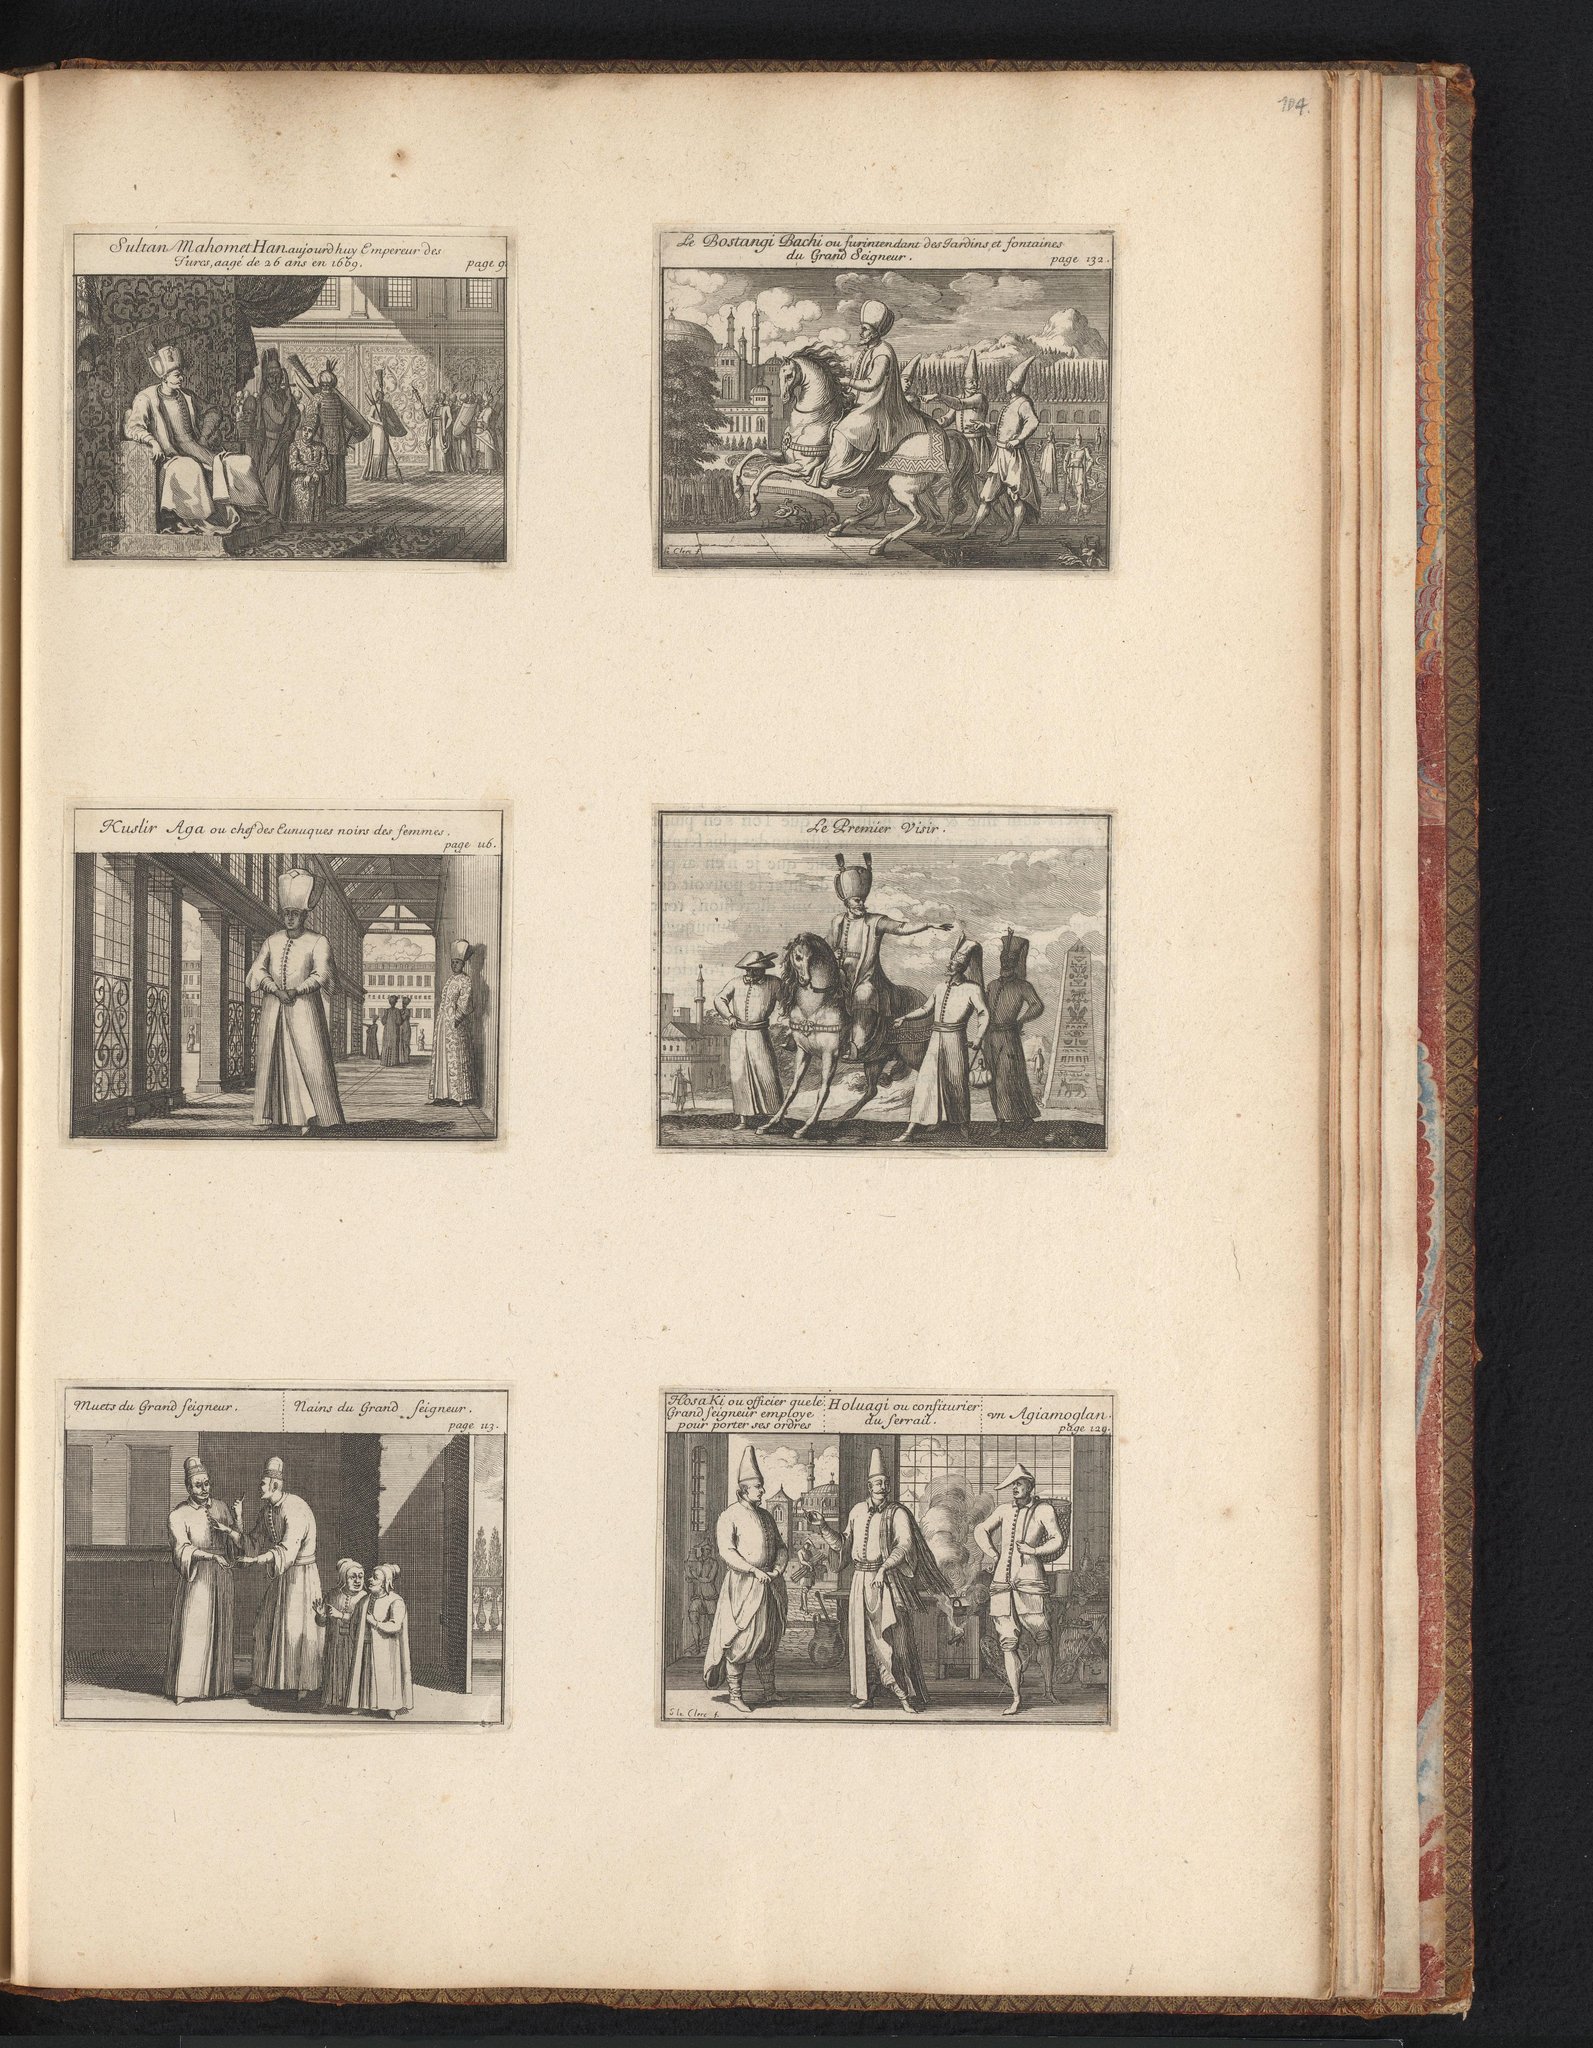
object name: print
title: Personen uit het Ottomaanse Rijk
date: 1670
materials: paper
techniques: engraving, etching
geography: paris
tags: little people, historical persons, ranks ~ rulers, sovereigns, eunuch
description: Prenten uit: Rycaut, Paul. Histoire de l'état présent de l'Empire ottoman (...). Parijs: Sébastien Mabre-Cramoisy, 1670.